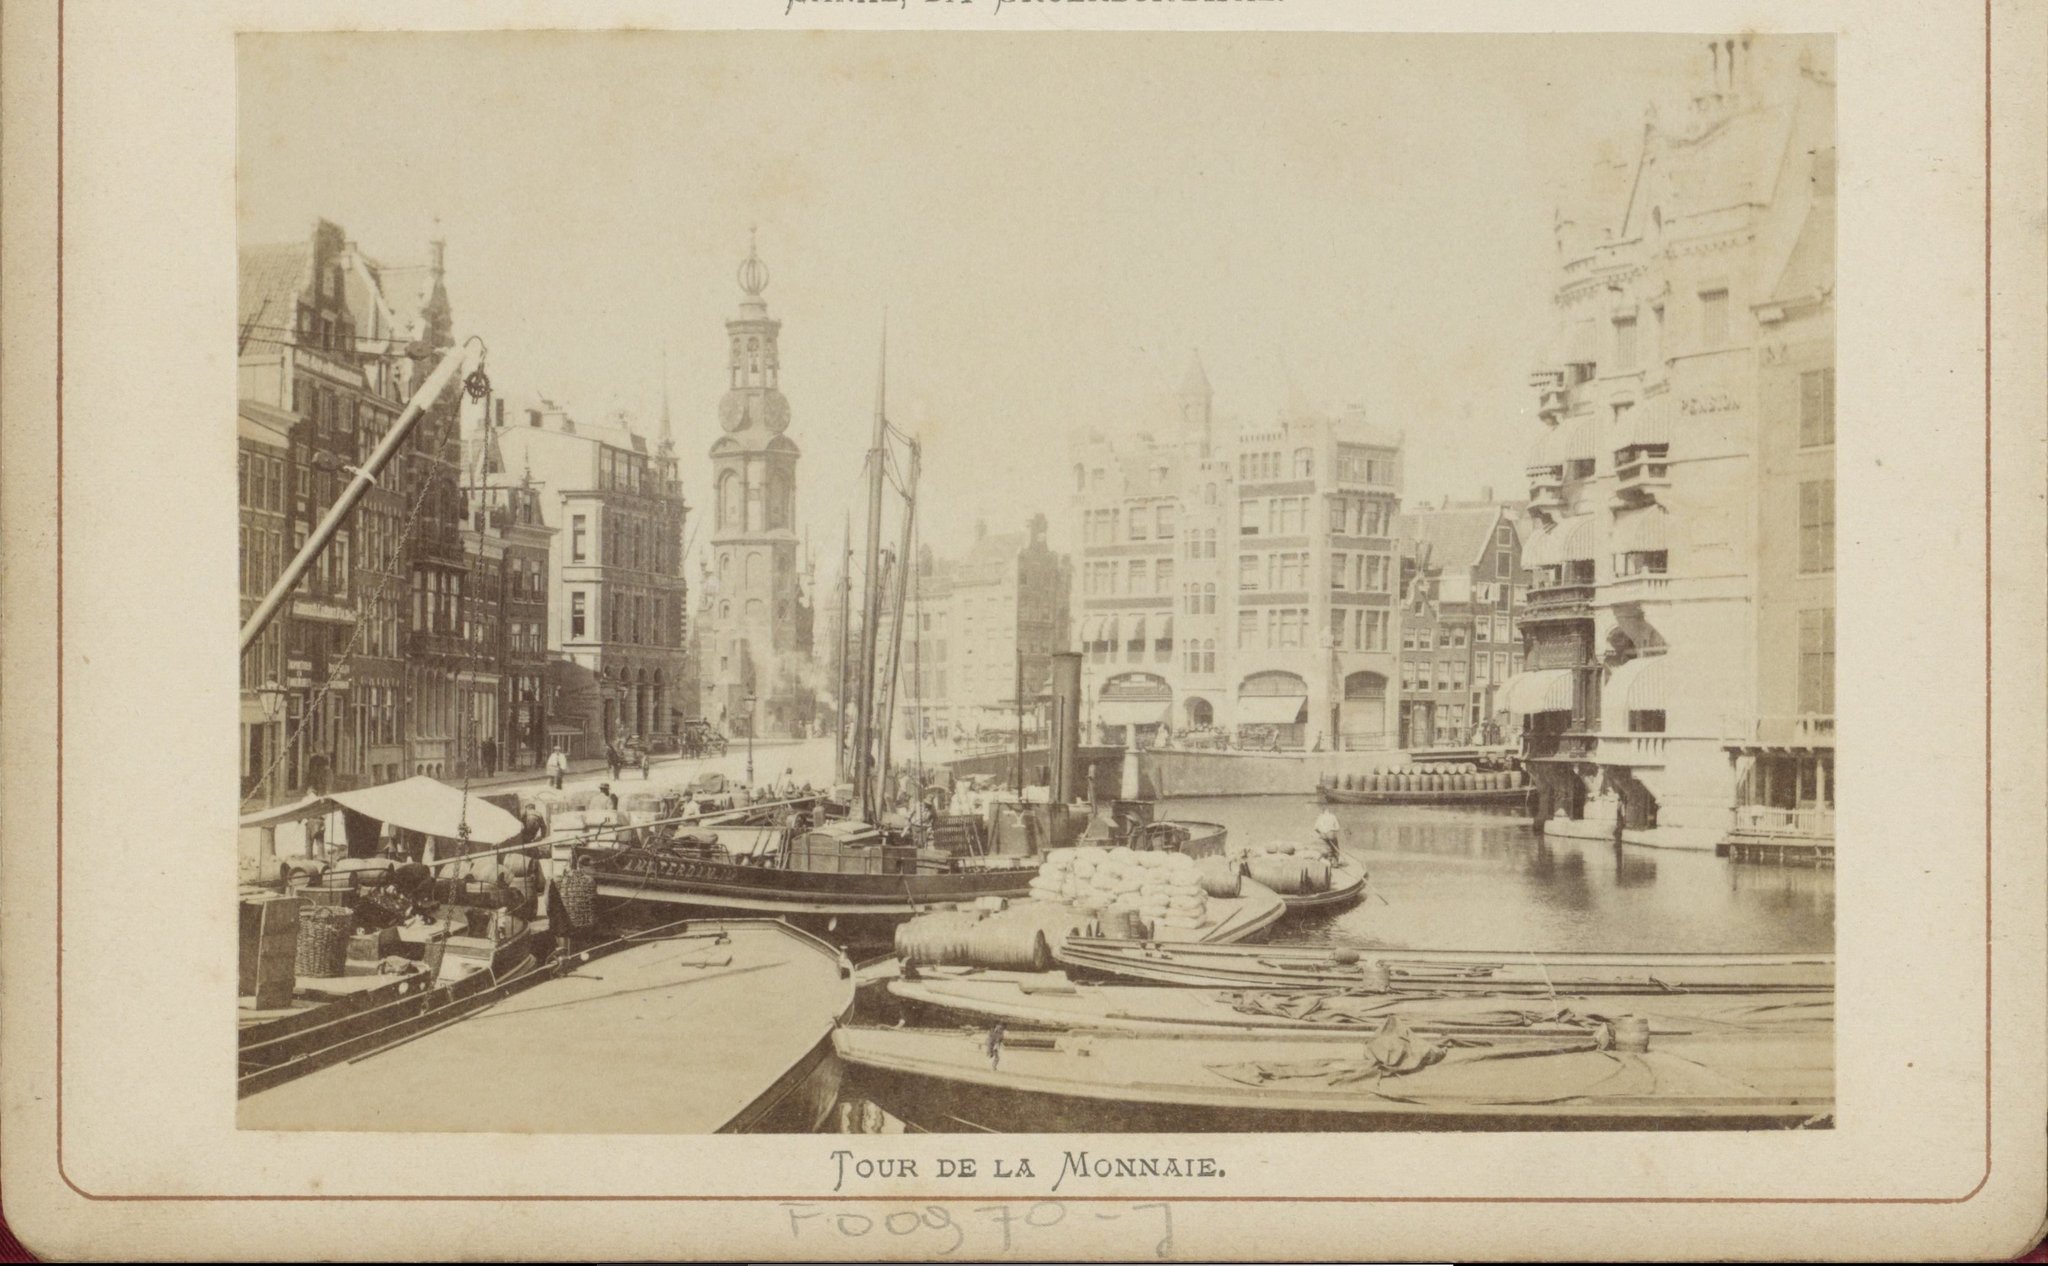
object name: photograph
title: Binnen Amstel gezien naar Sophiaplein (Muntplein) in Amsterdam met links de Munttoren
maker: andries jager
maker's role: publisher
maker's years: 1825-1905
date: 1875-1910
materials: cardboard, paper, photographic support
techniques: albumen print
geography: amsterdam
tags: towers ~ fortified city, canal, ships (in general)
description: Onderdeel van Leporelloalbum met 28 foto's van Amsterdam en omstreken.